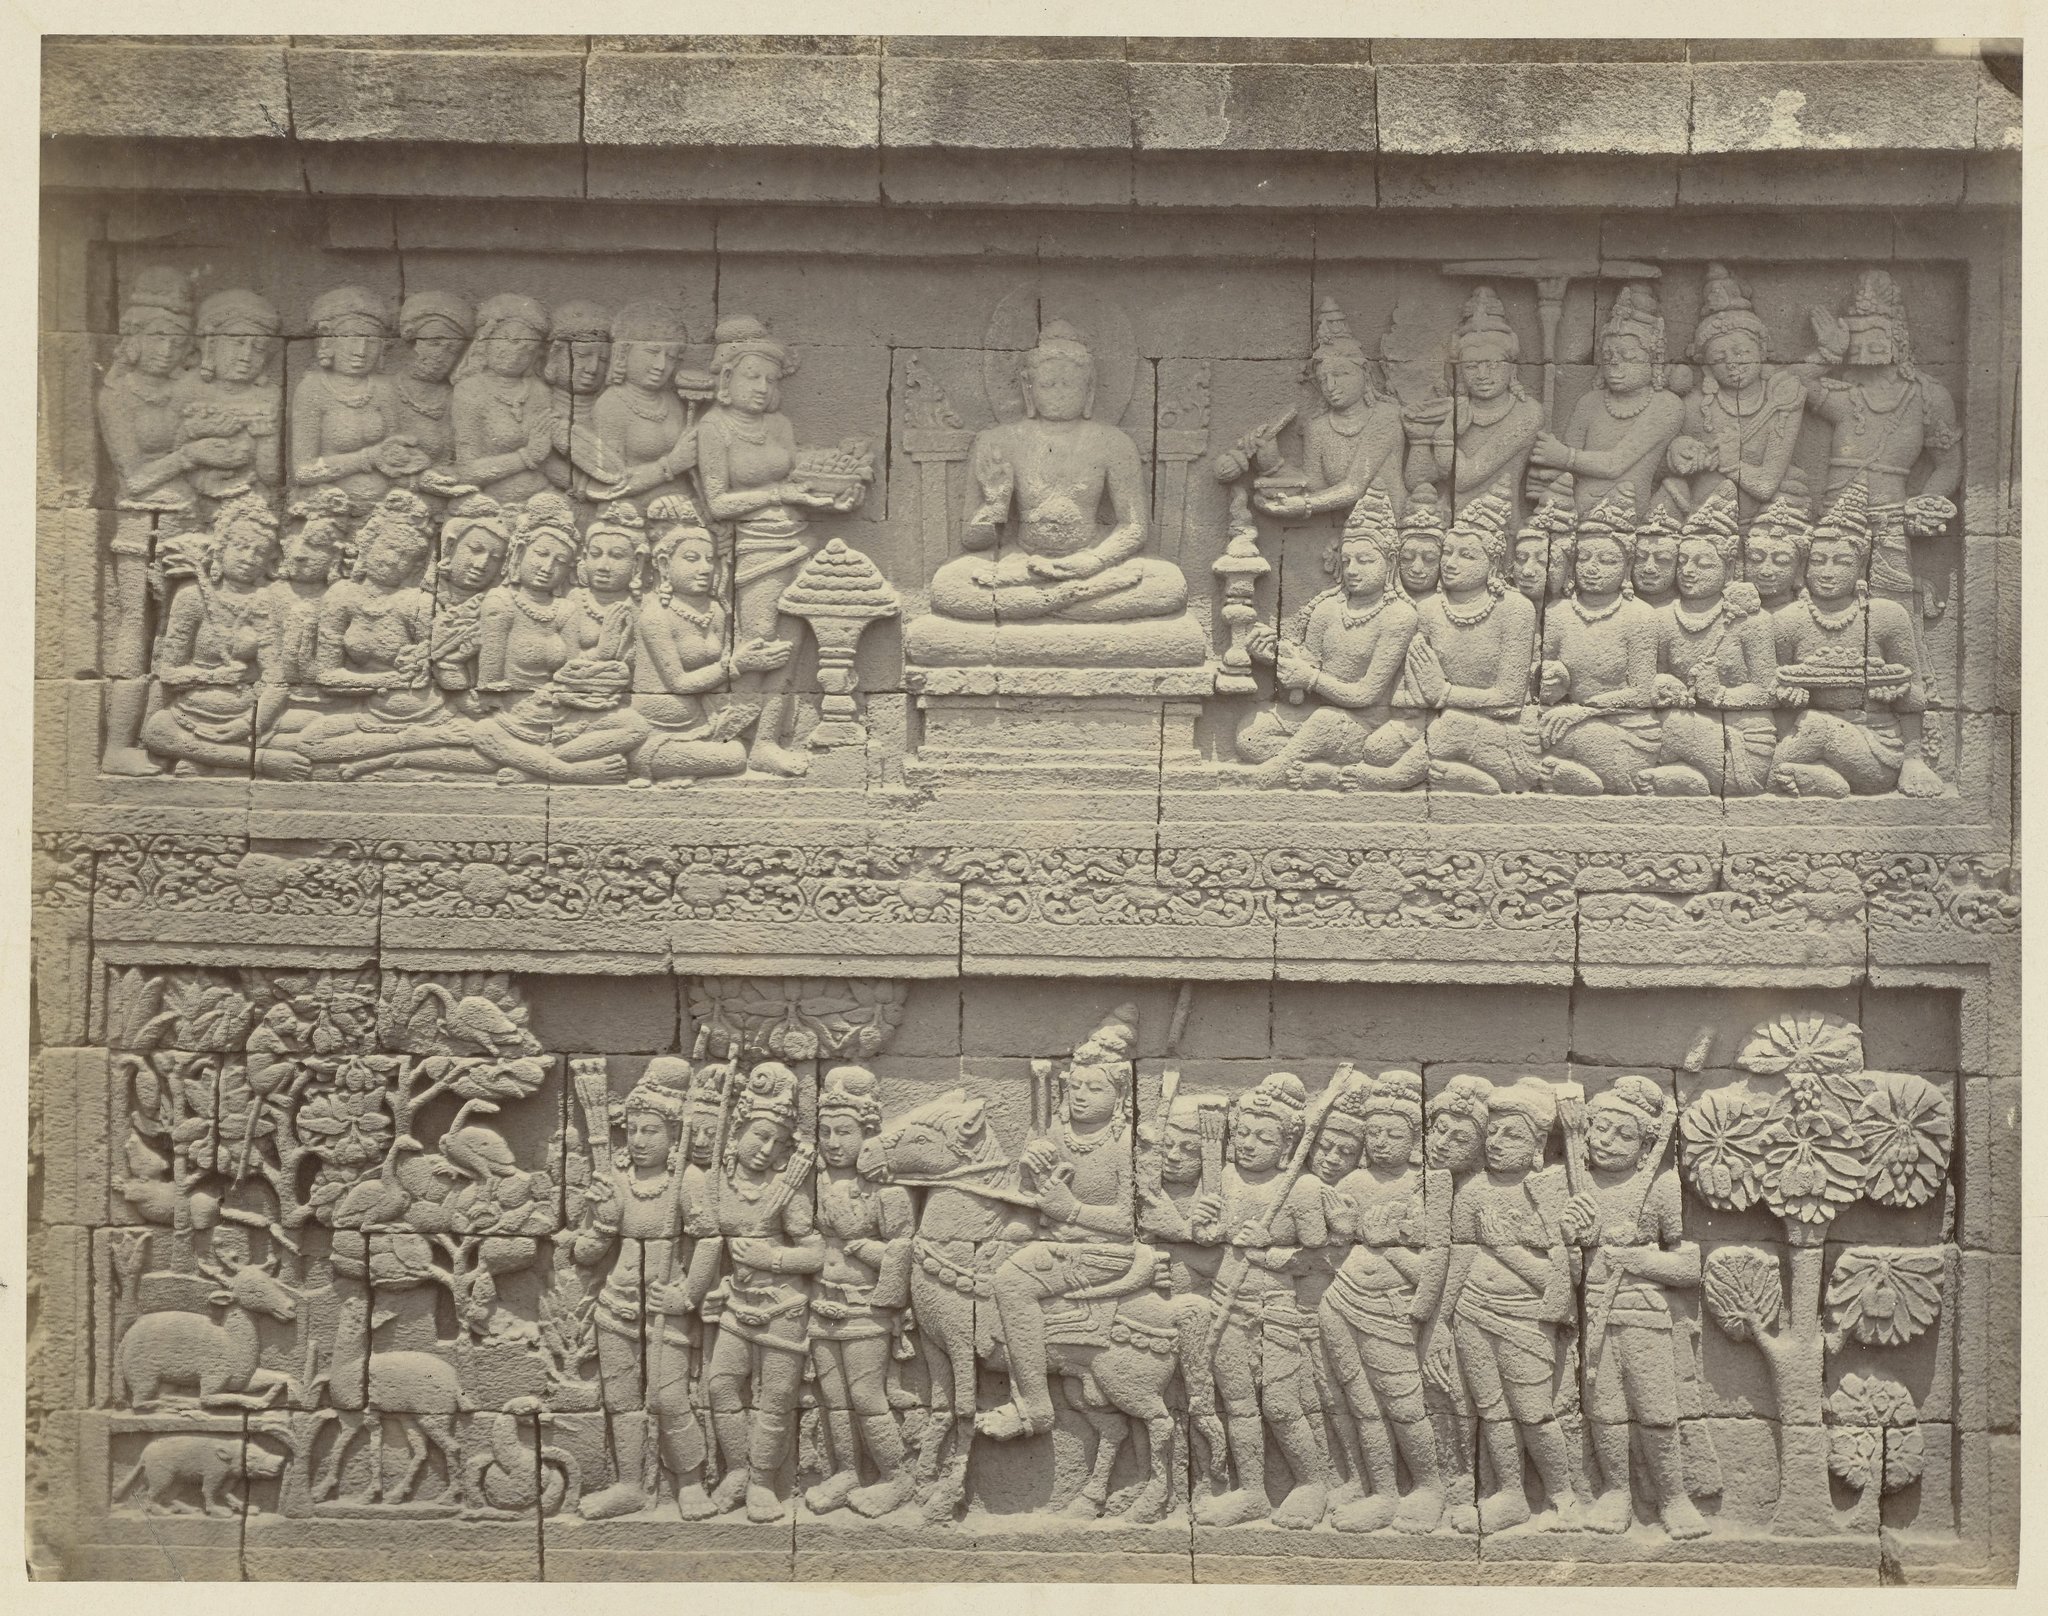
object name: photograph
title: Idem 2e gaanderij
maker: isidore kinsbergen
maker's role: fotograaf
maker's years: 1821-1905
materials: cardboard, paper, photographic support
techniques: albumen print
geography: java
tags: borobudur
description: Gallery I, main wall, east side 61 (top): Relief 1a-114, Lalitavistara relief, the Buddha receiving gifts. 62 (bottom): relief 1b-114, unidentified scene. Borobudur village, Magelang district, Central Java province, 778-824 AD.